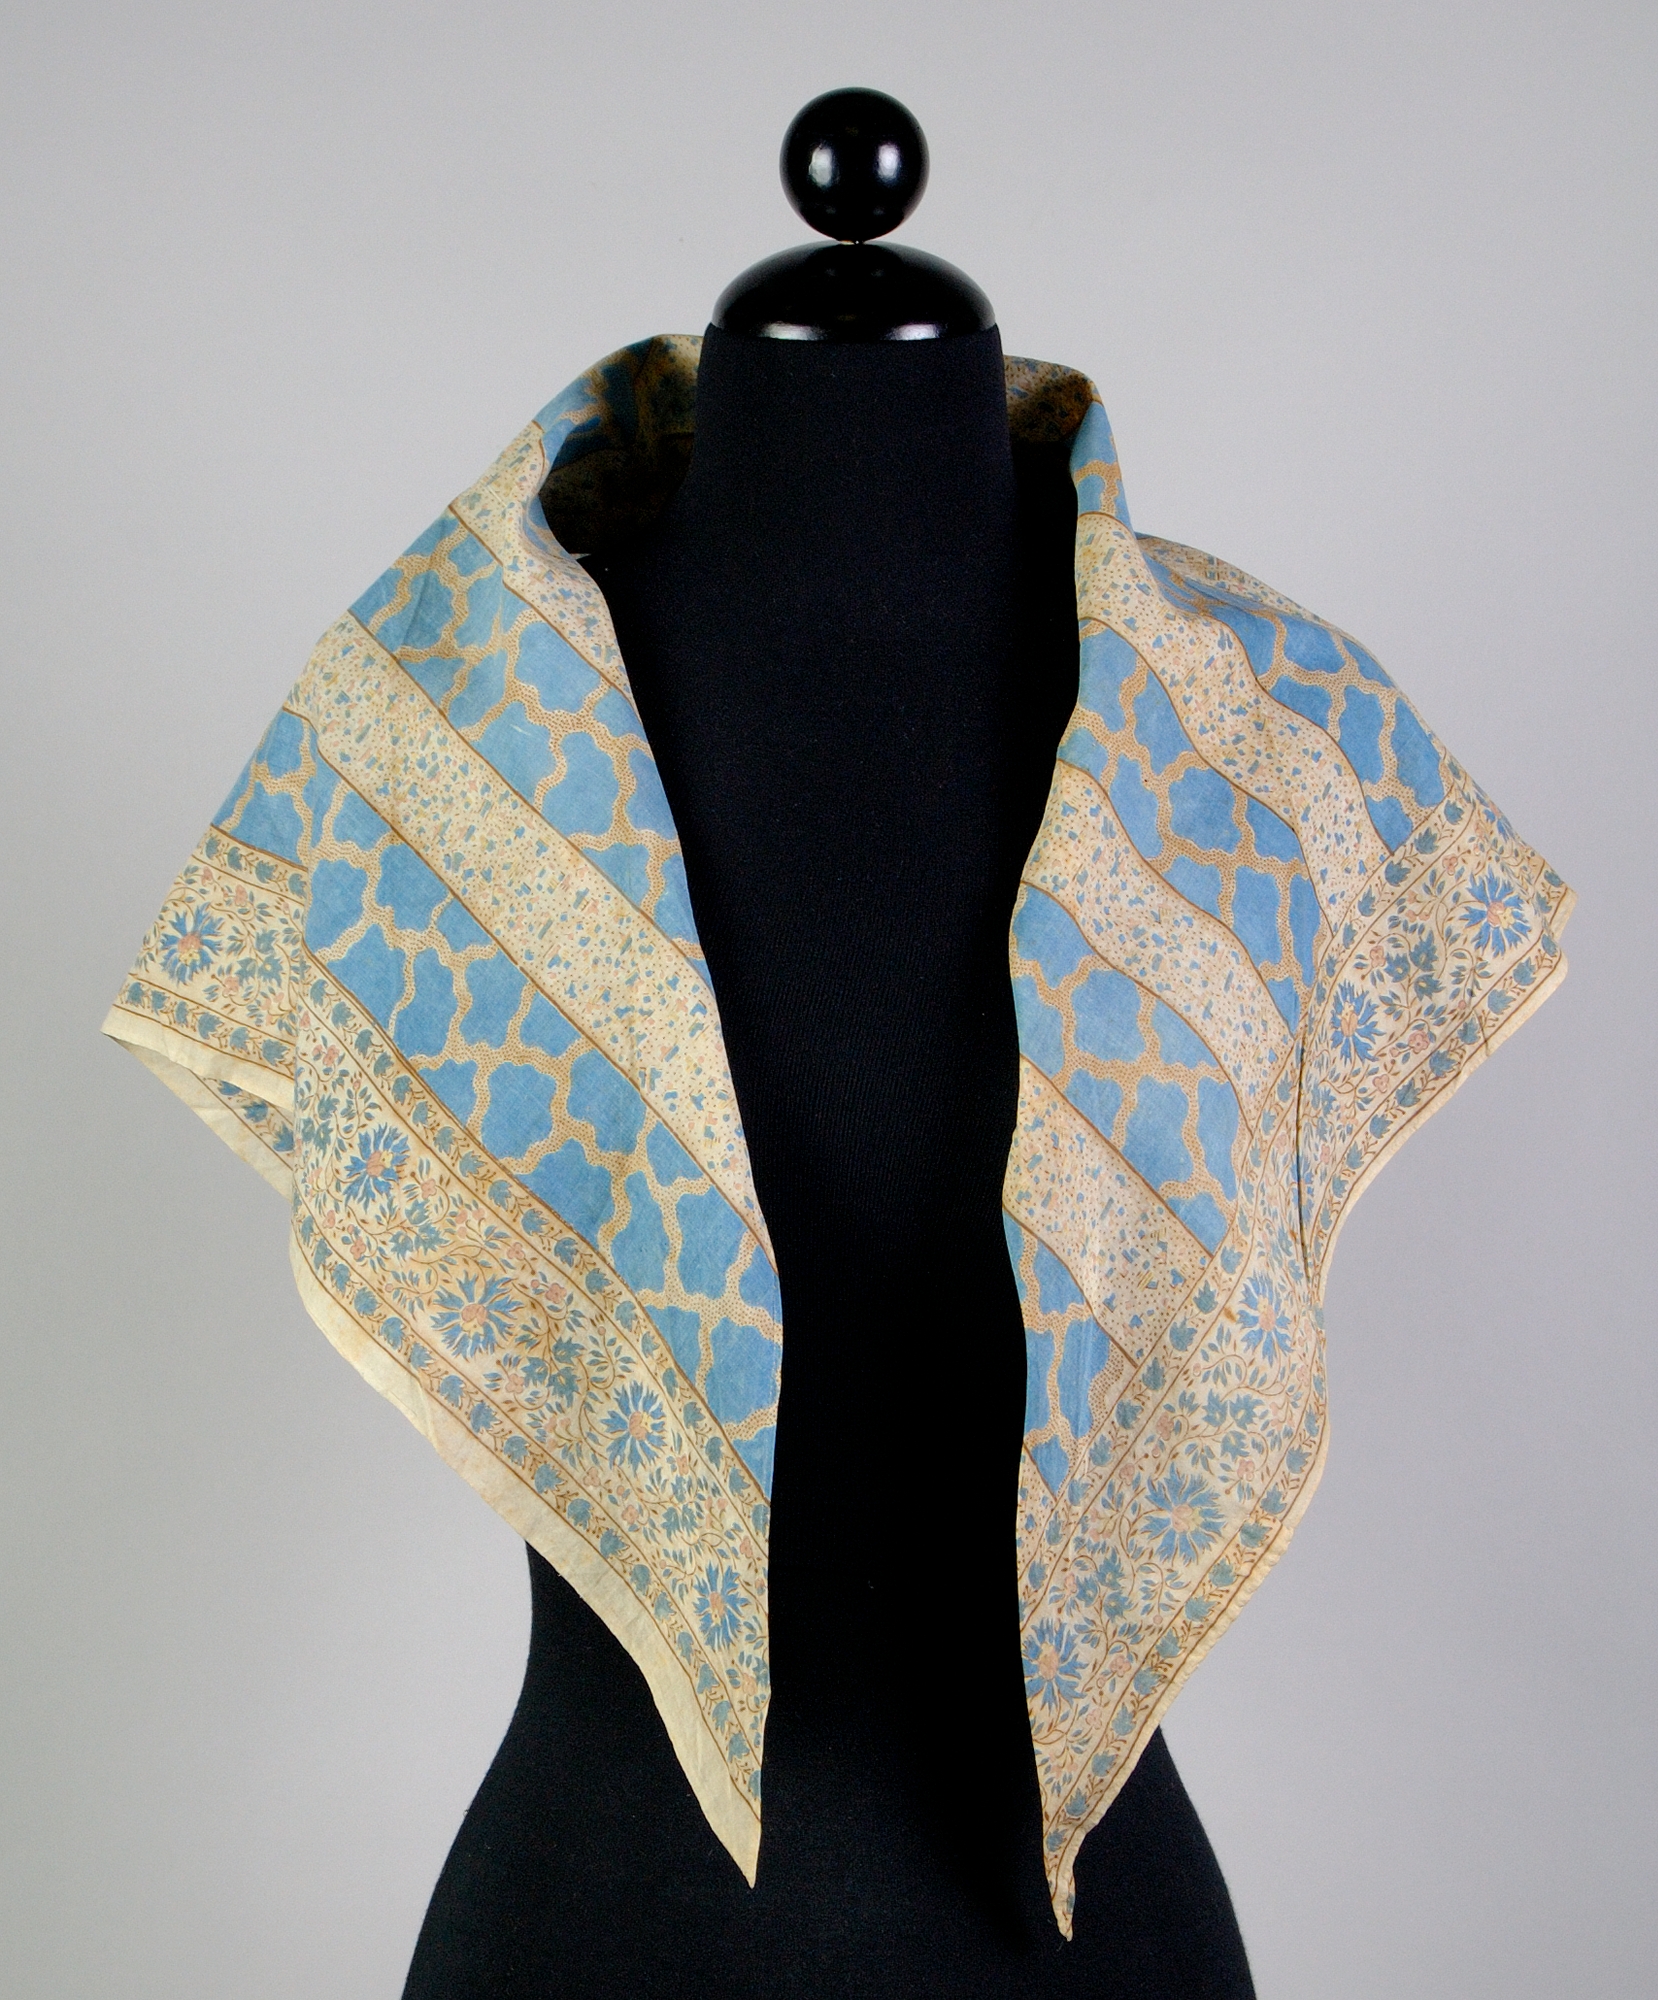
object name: kerchief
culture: american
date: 1840-1850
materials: cotton